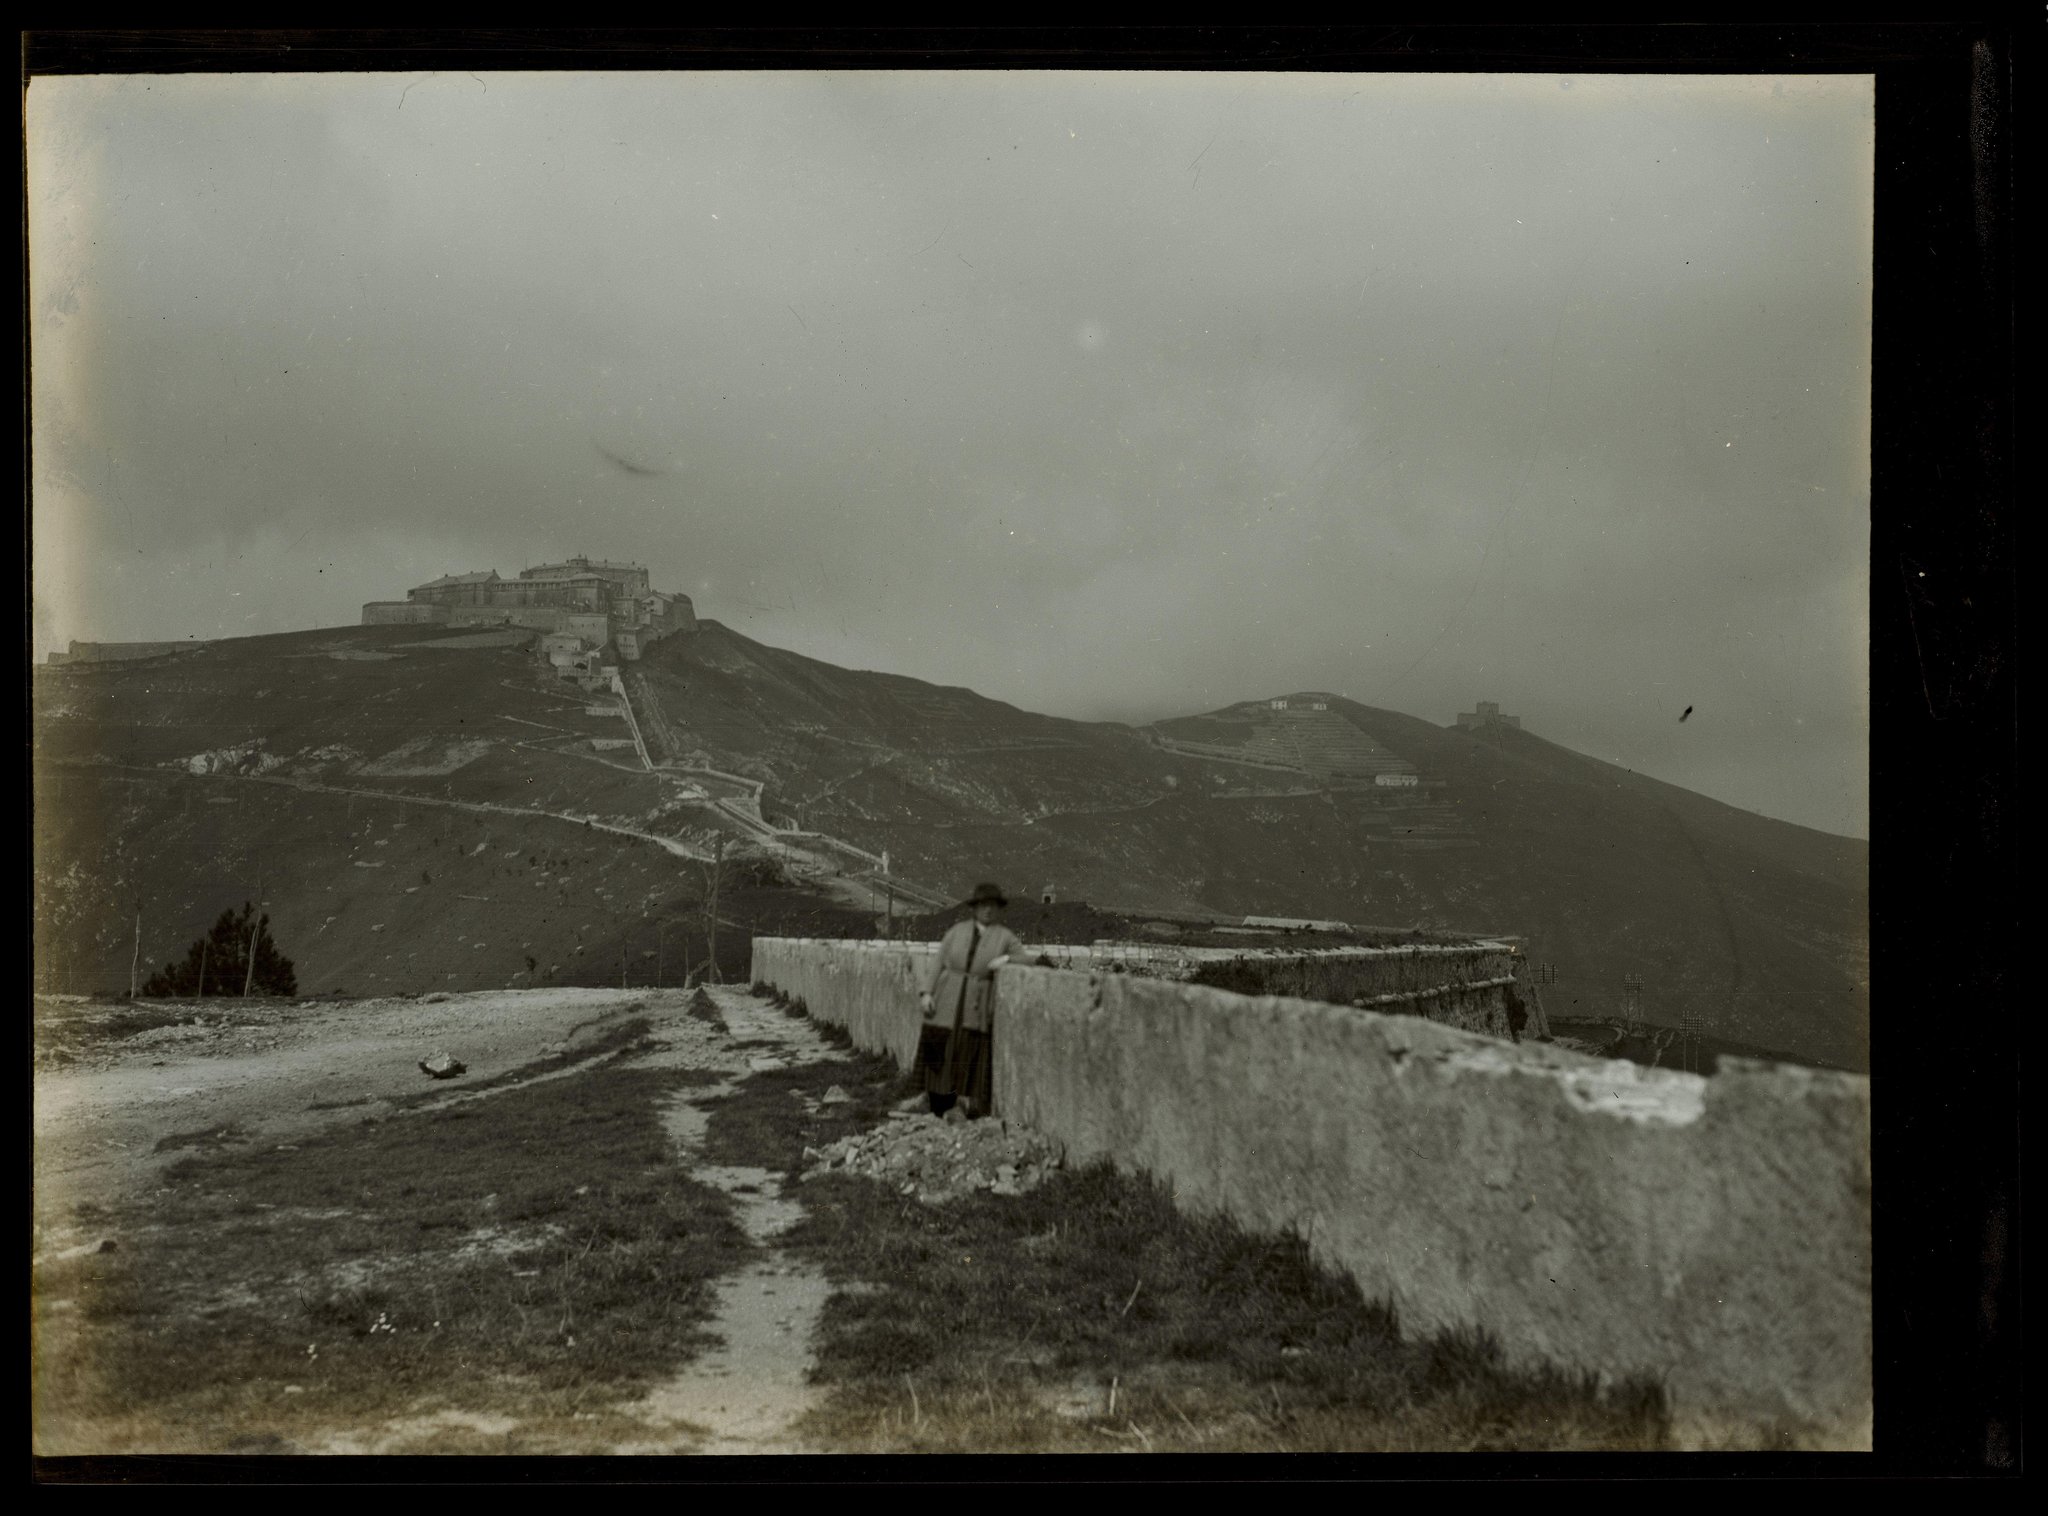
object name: photograph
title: Filmnegatief met opname van Genua, Pisa, Ravenna of Milaan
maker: Anonymous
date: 1907-1935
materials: film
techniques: gelatin silver negative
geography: italy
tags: italy